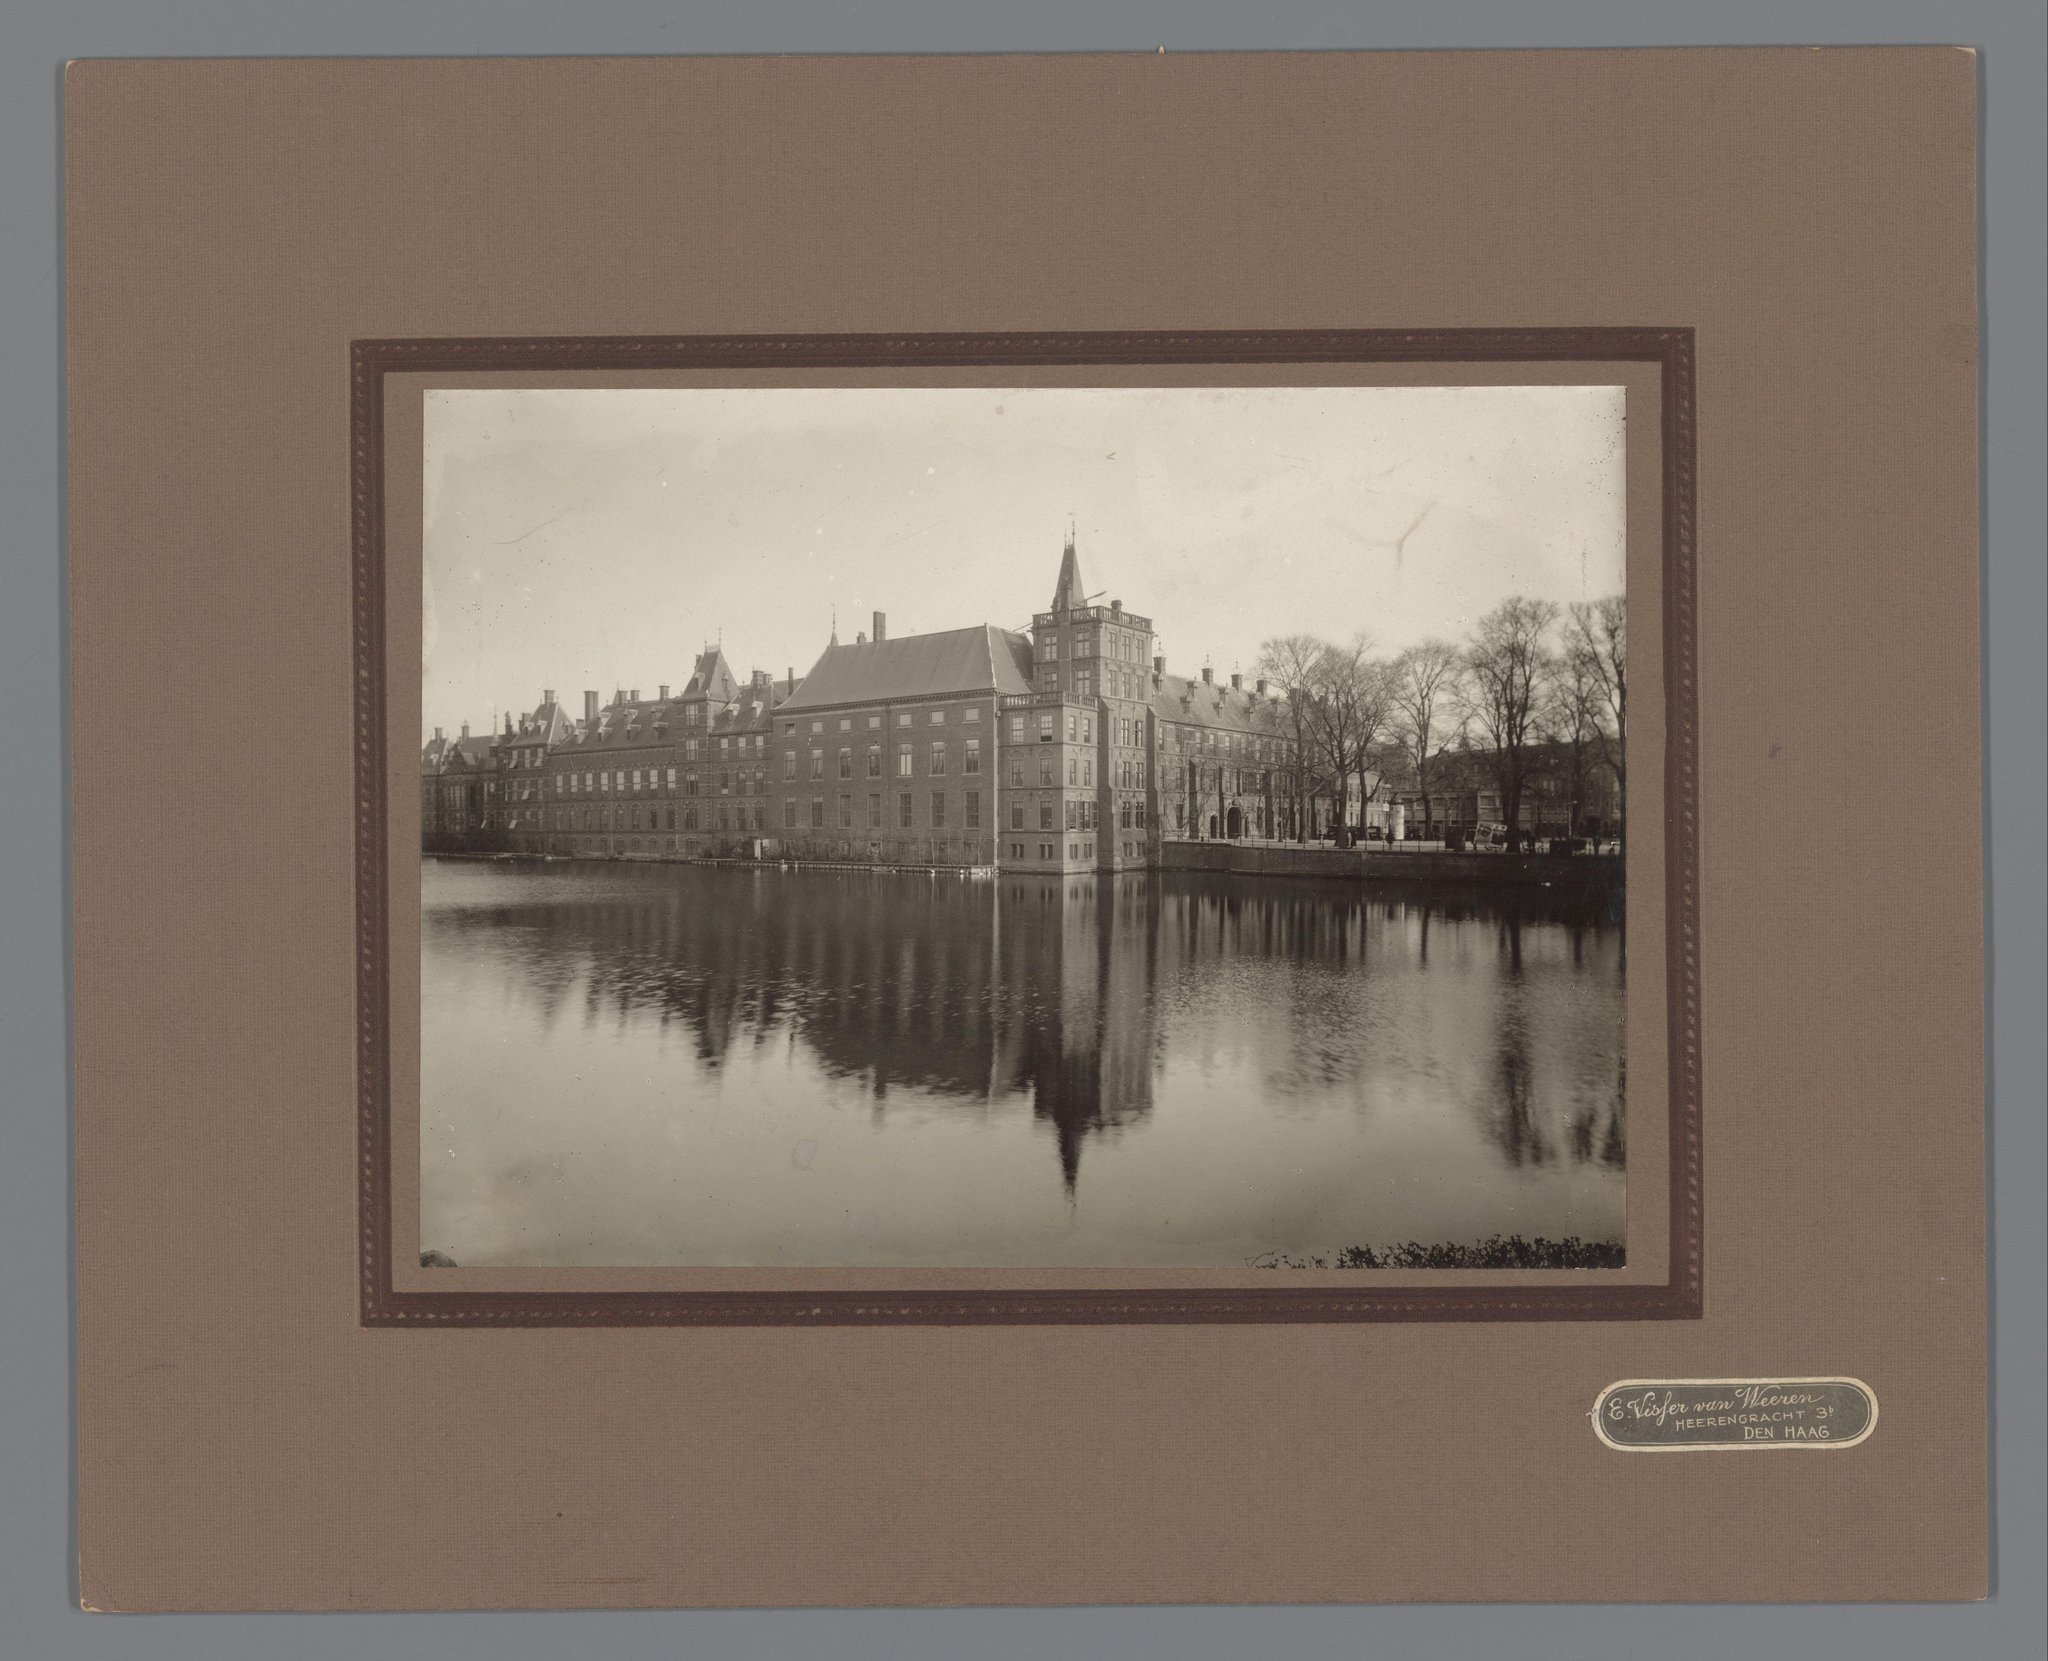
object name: photograph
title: Gezicht op de Hofvijver met het binnenhof te Den Haag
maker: e. visser von weeren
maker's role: fotograaf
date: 1900-1921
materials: cardboard, photographic support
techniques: gelatin silver print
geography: the hague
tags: national government, the hague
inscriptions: date: ‘19 mrt 1921’, number: ‘141/ no.22’, inscription: ‘E. Visser van Weeren/ Heerengracht 3b/ Den Haag’